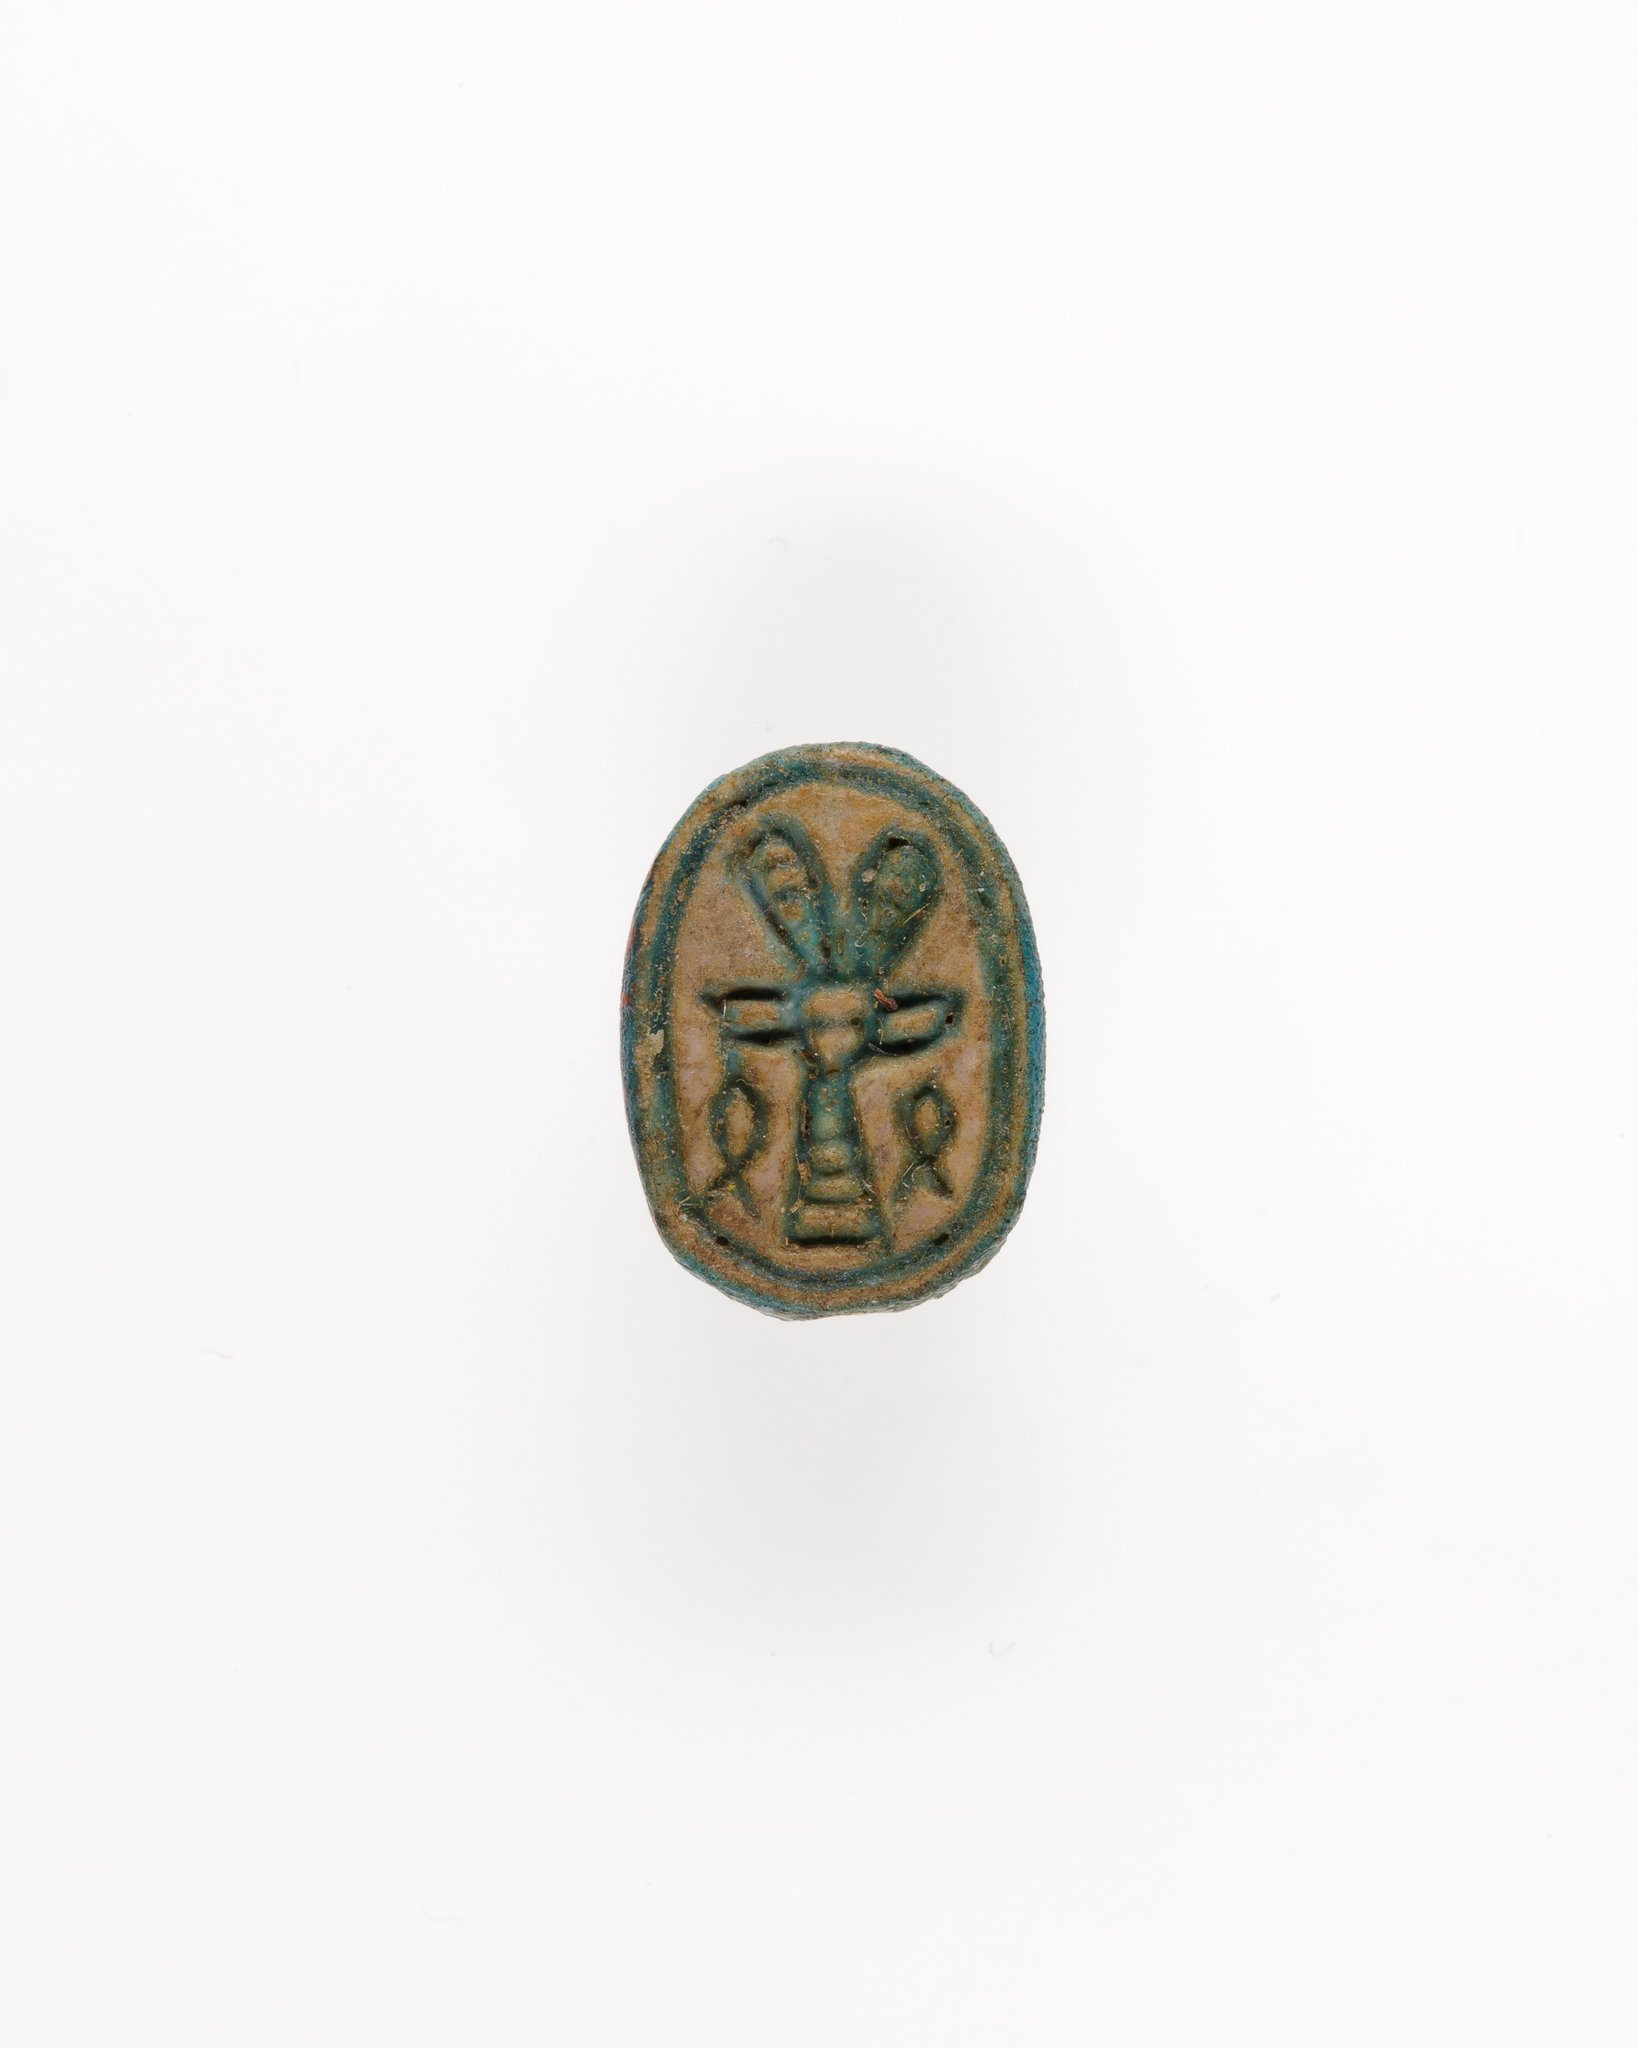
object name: scarab, canaanite goddess, 'hathor'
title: Scarab with Hathor-like Canaanite Goddess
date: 1740-1640 BCE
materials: stone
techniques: glazing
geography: egypt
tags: scarabs